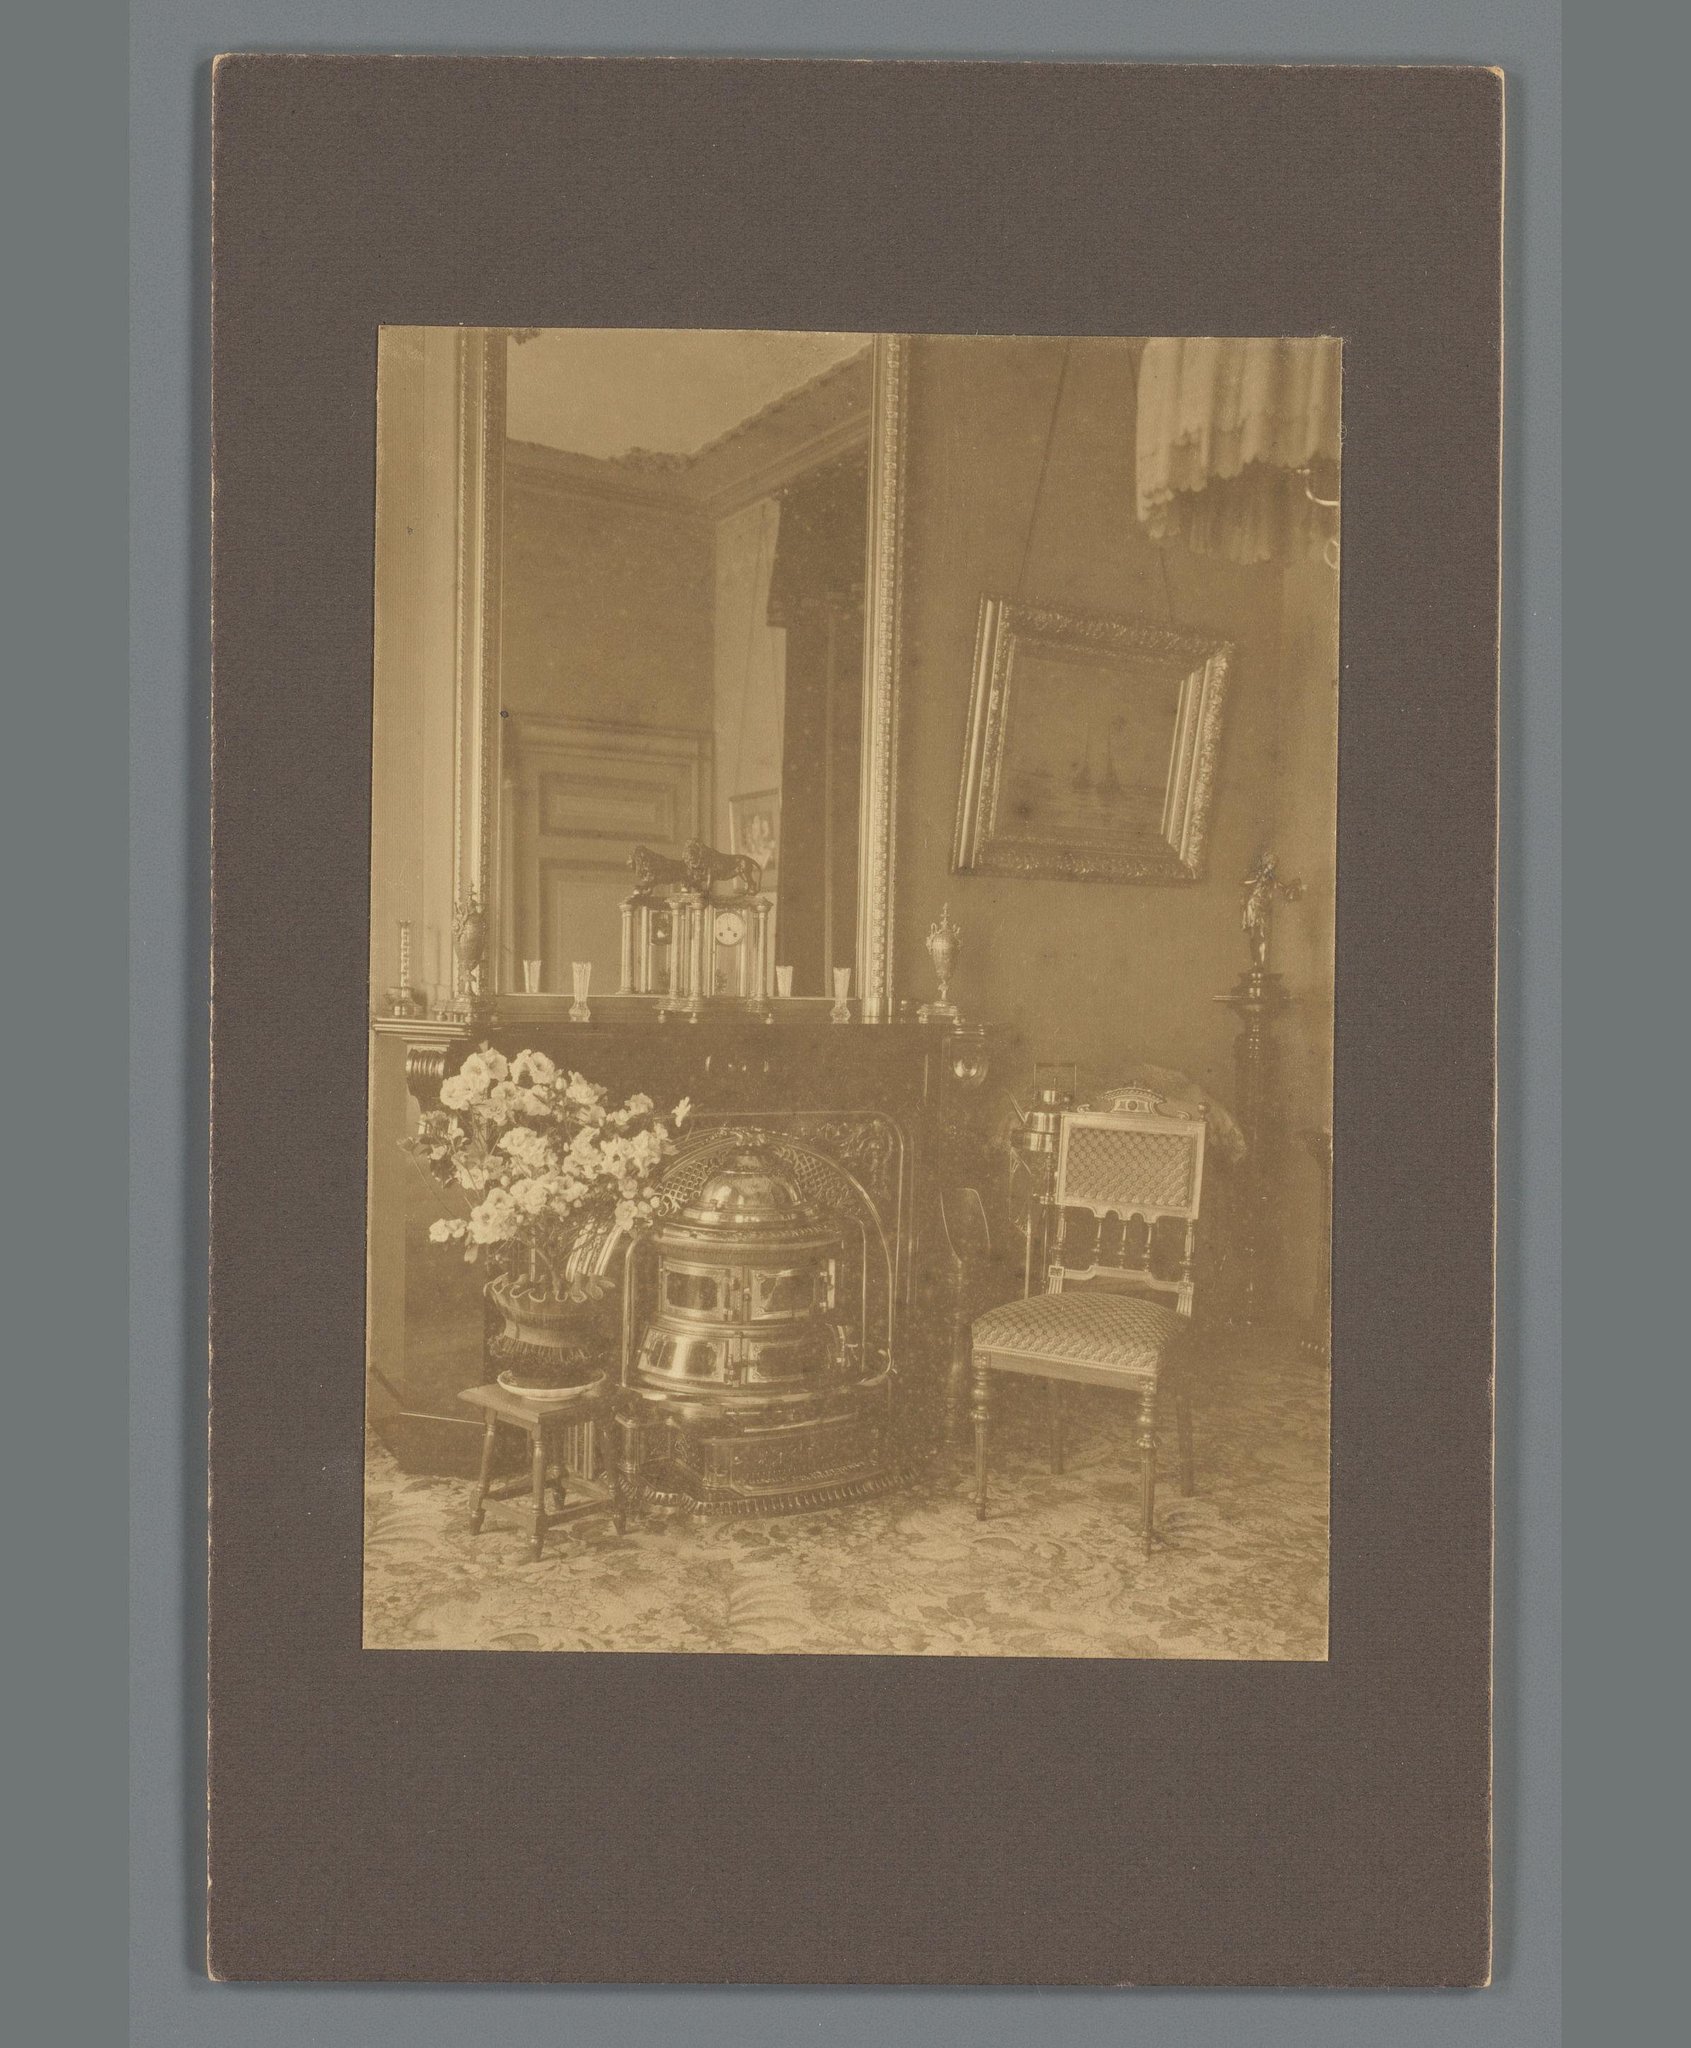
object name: photograph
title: Interieur van het huis van Piet de Jong in Arnhem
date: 1895-1920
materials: paper, cardboard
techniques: collodion silver print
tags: flowers, interior of the house